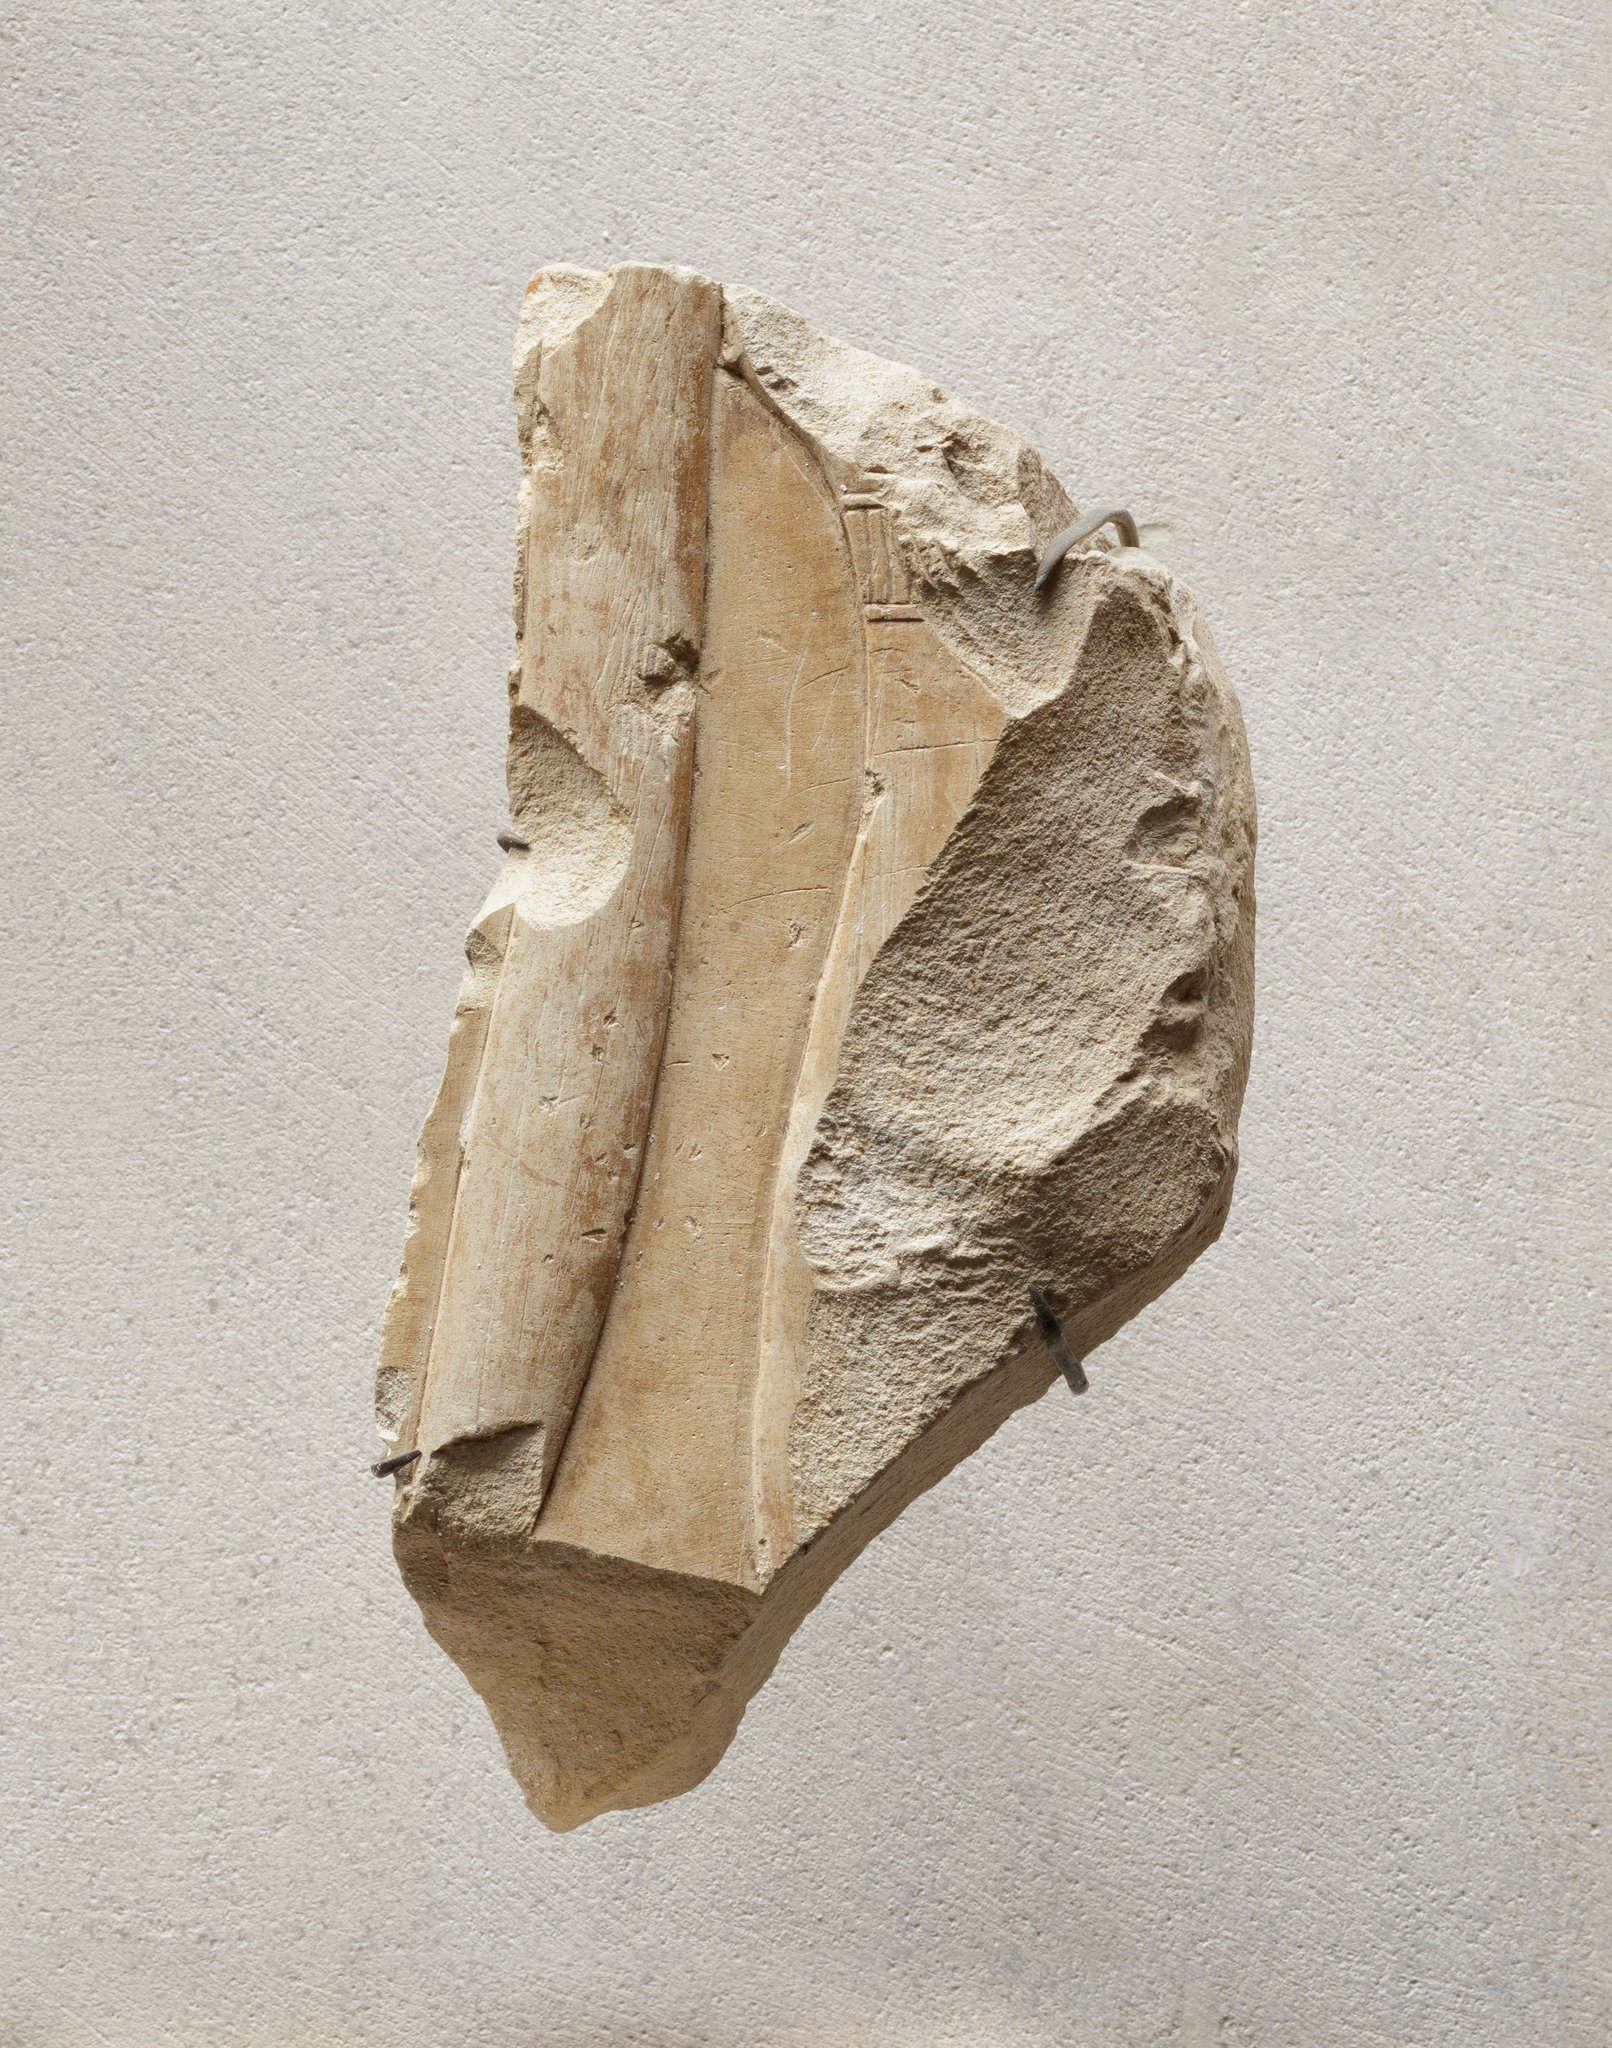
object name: relief fragment, tomb of neferu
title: Relief of part of a female attendant - see 26.3.353-3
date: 2051-2030 BCE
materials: limestone, paint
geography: egypt